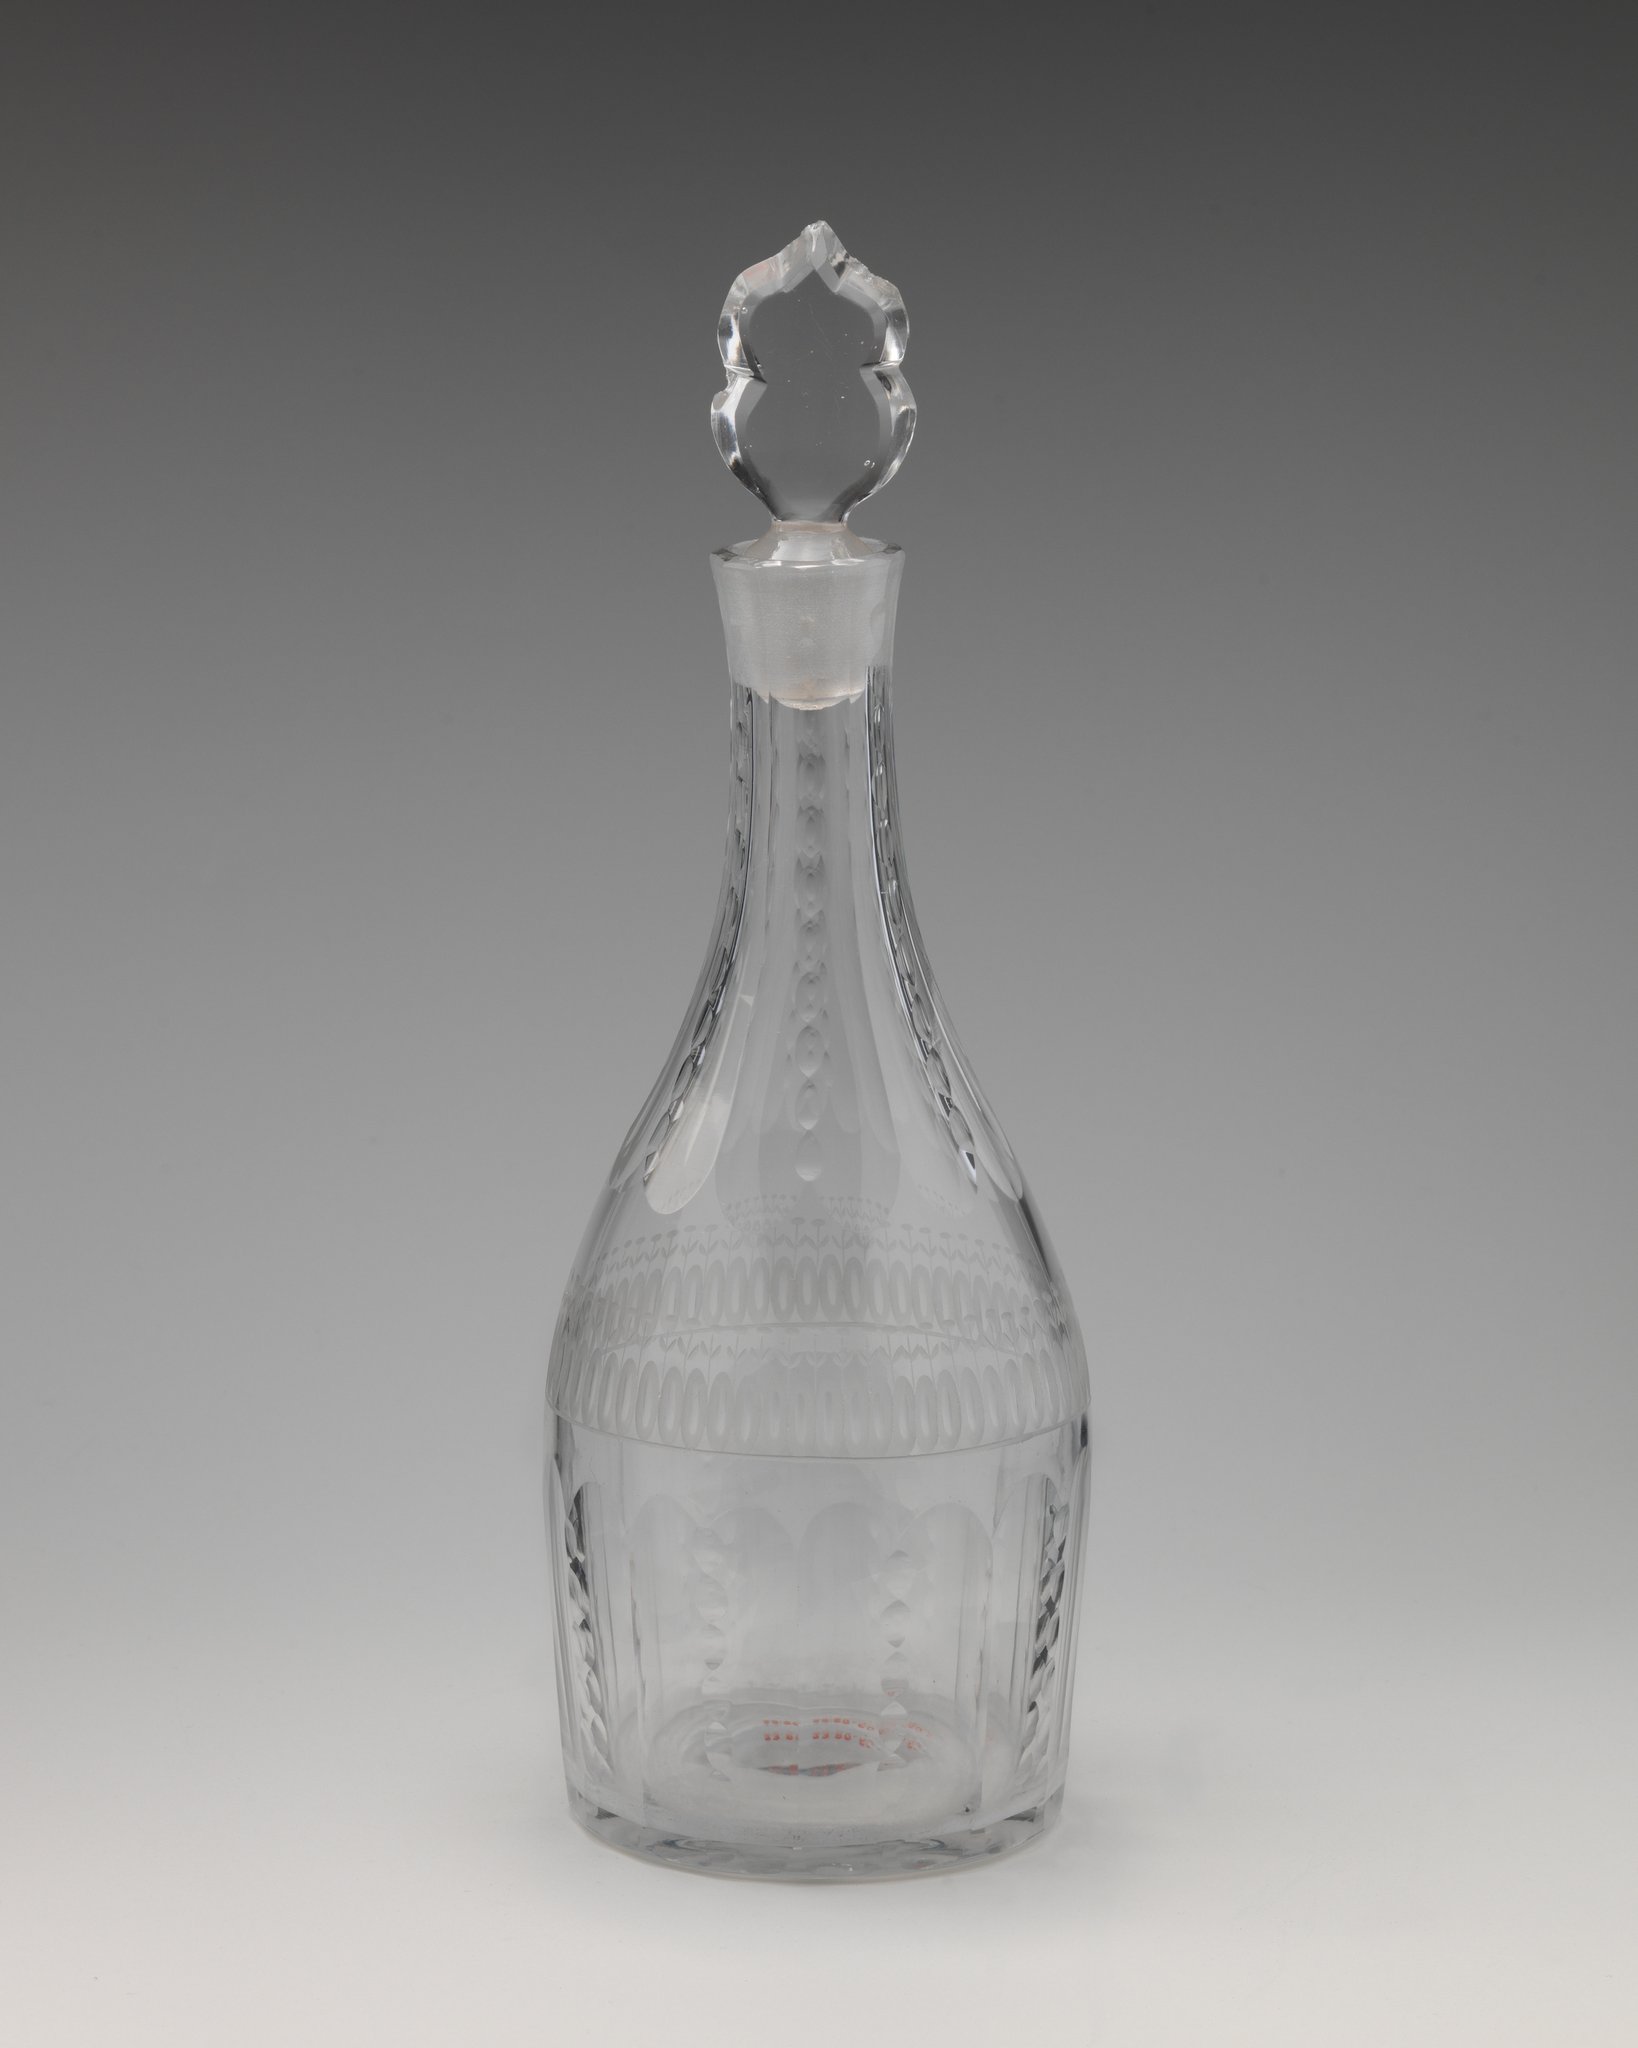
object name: decanter with stopper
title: Decanter with stopper (one of a pair)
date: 1767-1800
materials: glass